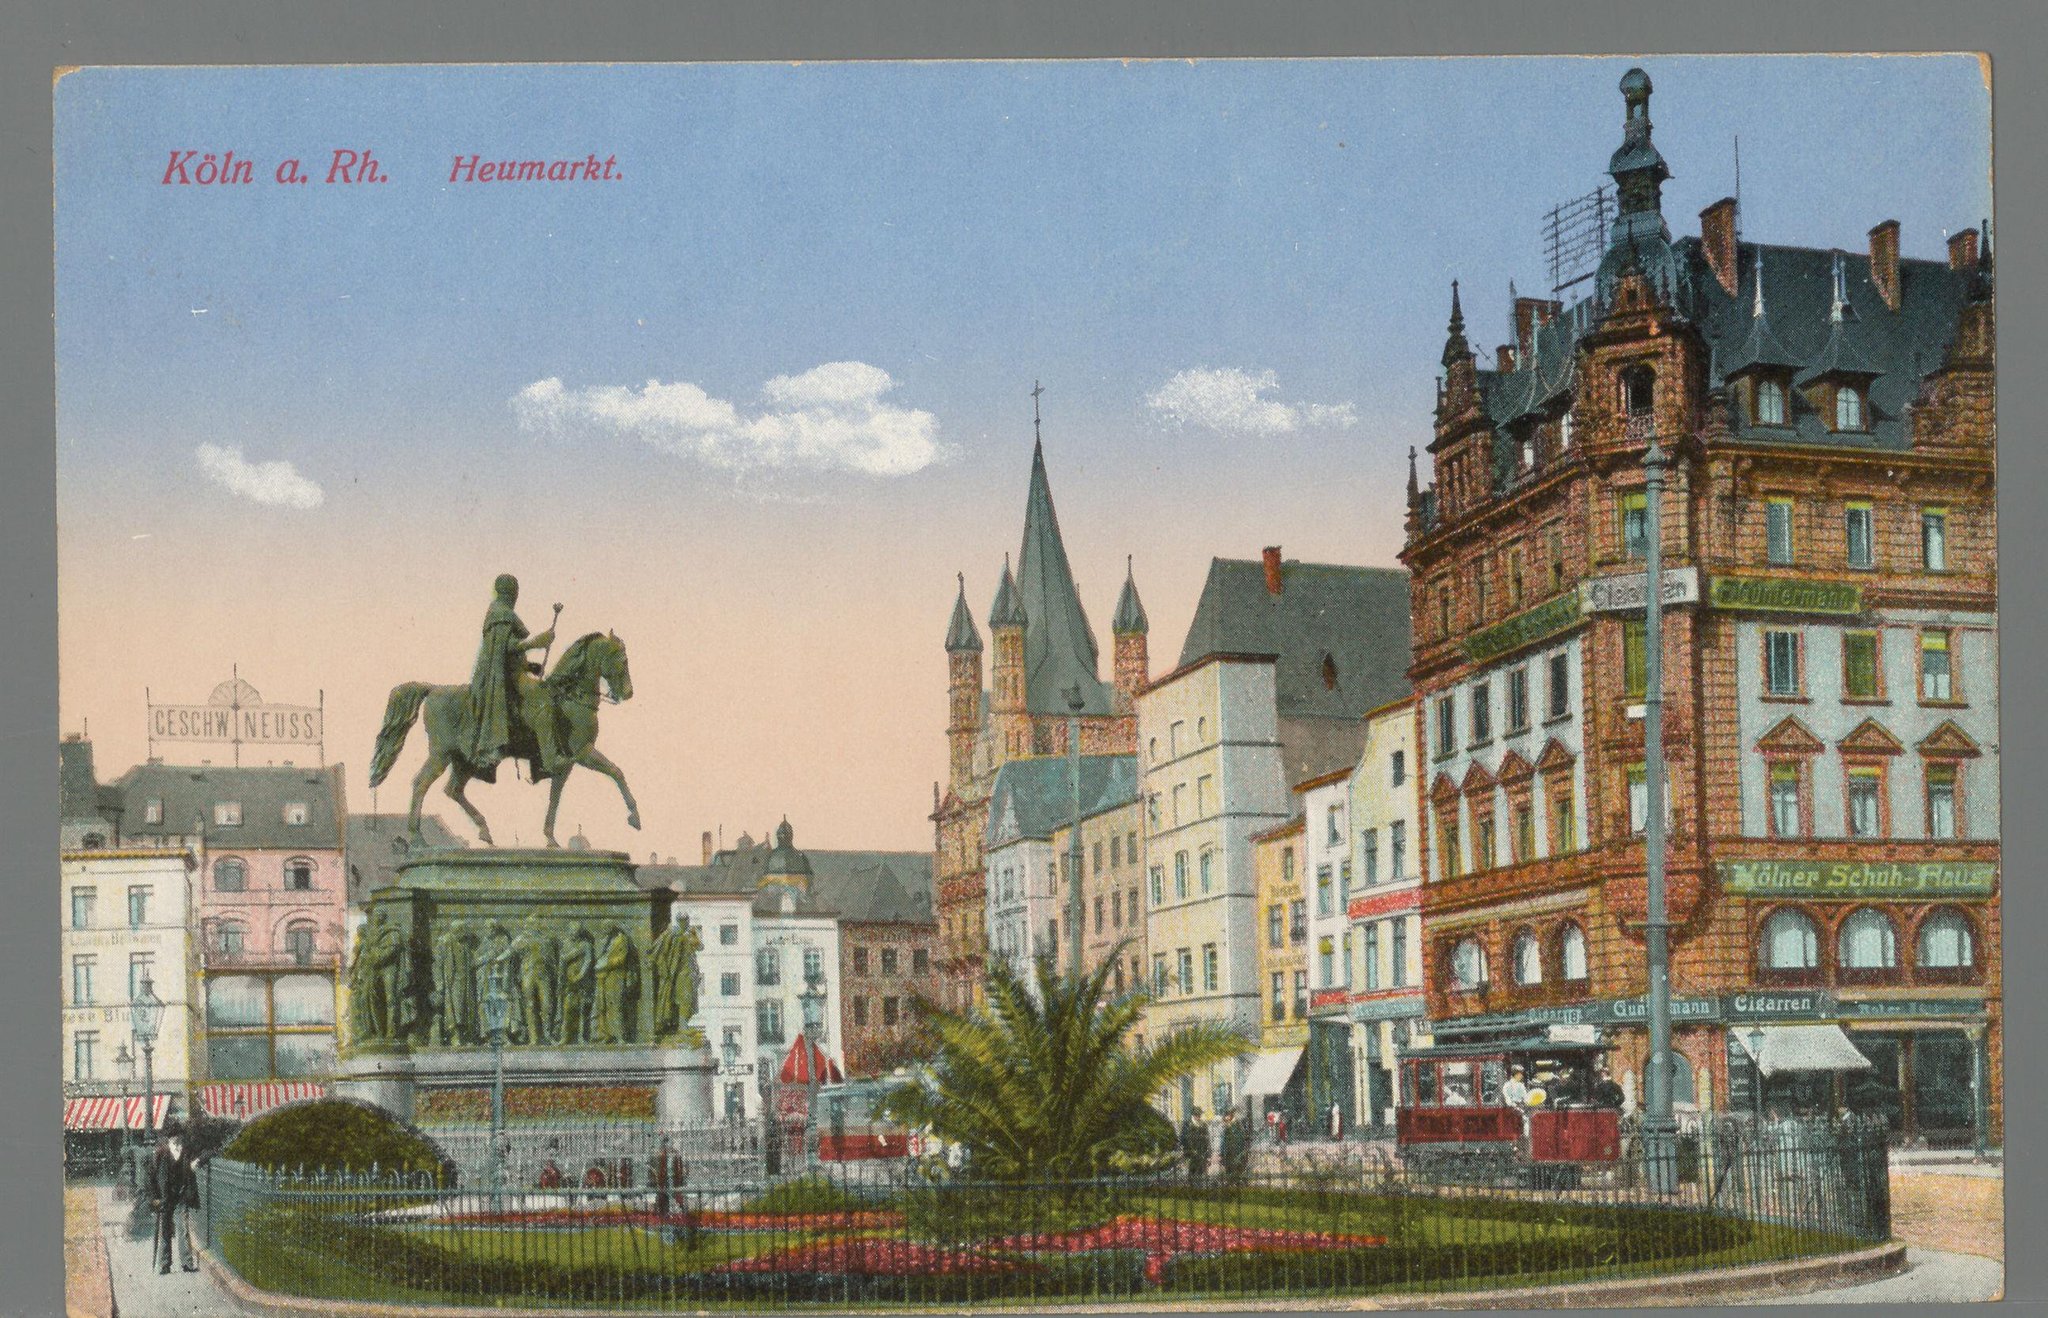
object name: photomechanical print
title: Köln a. Rh. Heumarkt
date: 1905-1930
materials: cardboard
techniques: lithograph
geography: leipzig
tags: square, place, circus, etc., monument, statue, cologne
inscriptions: inscription: ‘H. & St. L.’